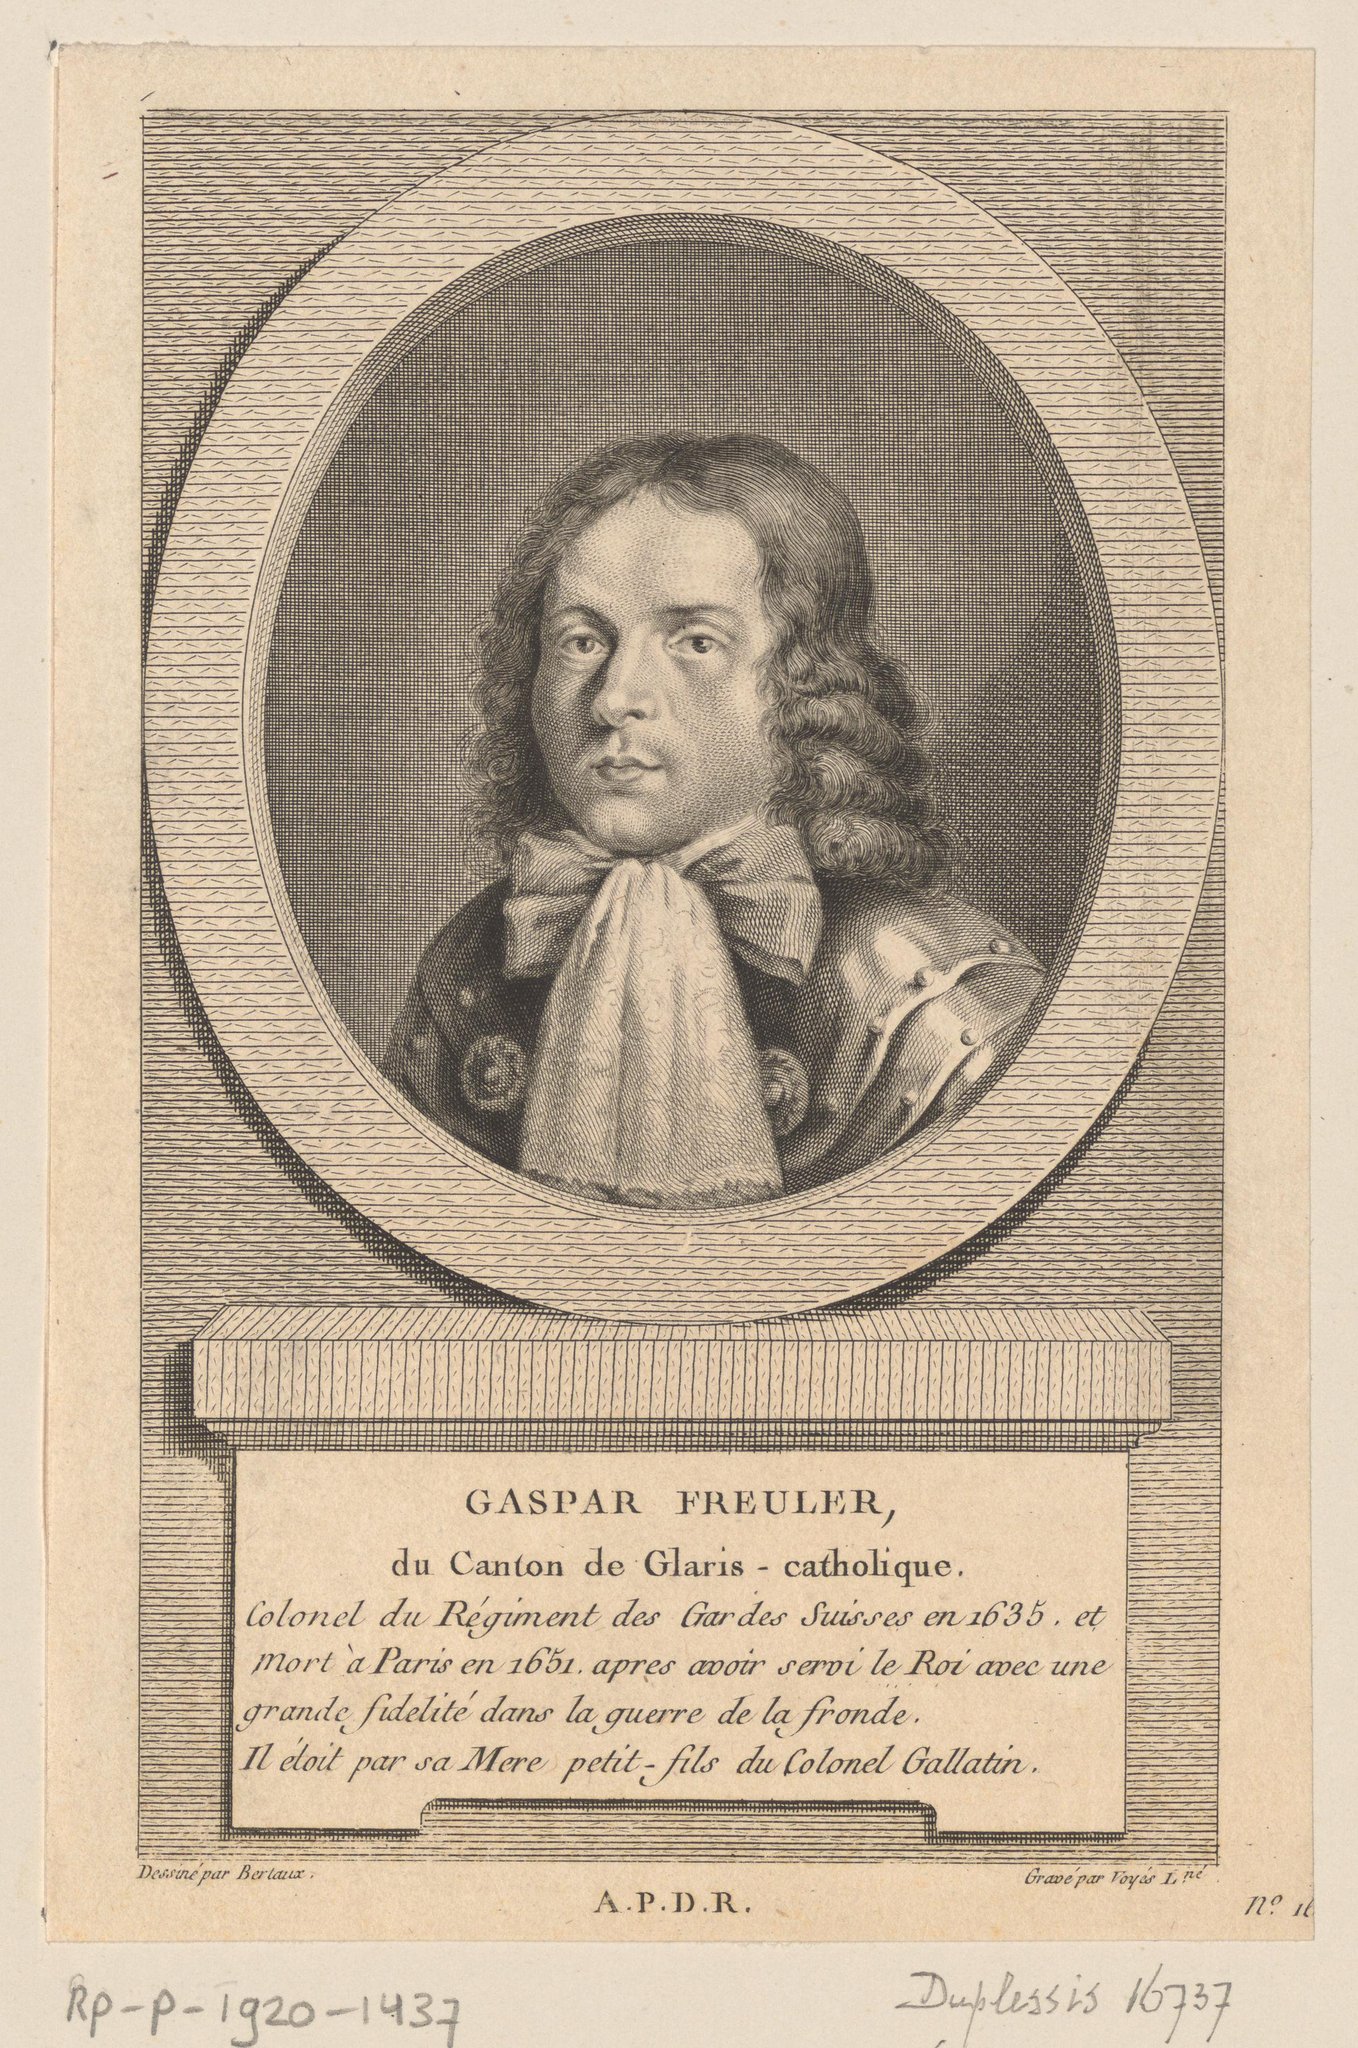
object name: print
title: Portret van Kaspar Freuler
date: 1785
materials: paper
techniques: engraving, etching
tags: switzerland, france, armour, historical persons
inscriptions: collector's mark: Lugt 2228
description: Latere staat gebruikt in: Zurlauben, Béat Fidèle Antoine Dominique. Tableaux de la Suisse, ou, Voyage pittoresque fait dans les XIII cantons (...). Parijs: Lamy, 1785.